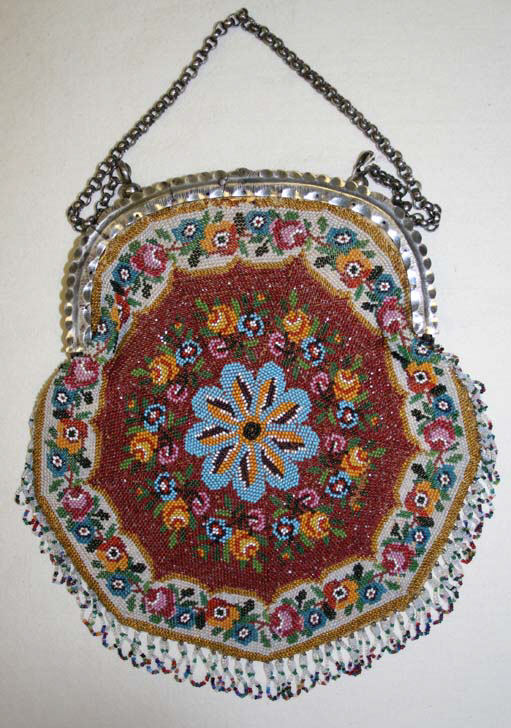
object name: bag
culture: french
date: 1820-1830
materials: metal